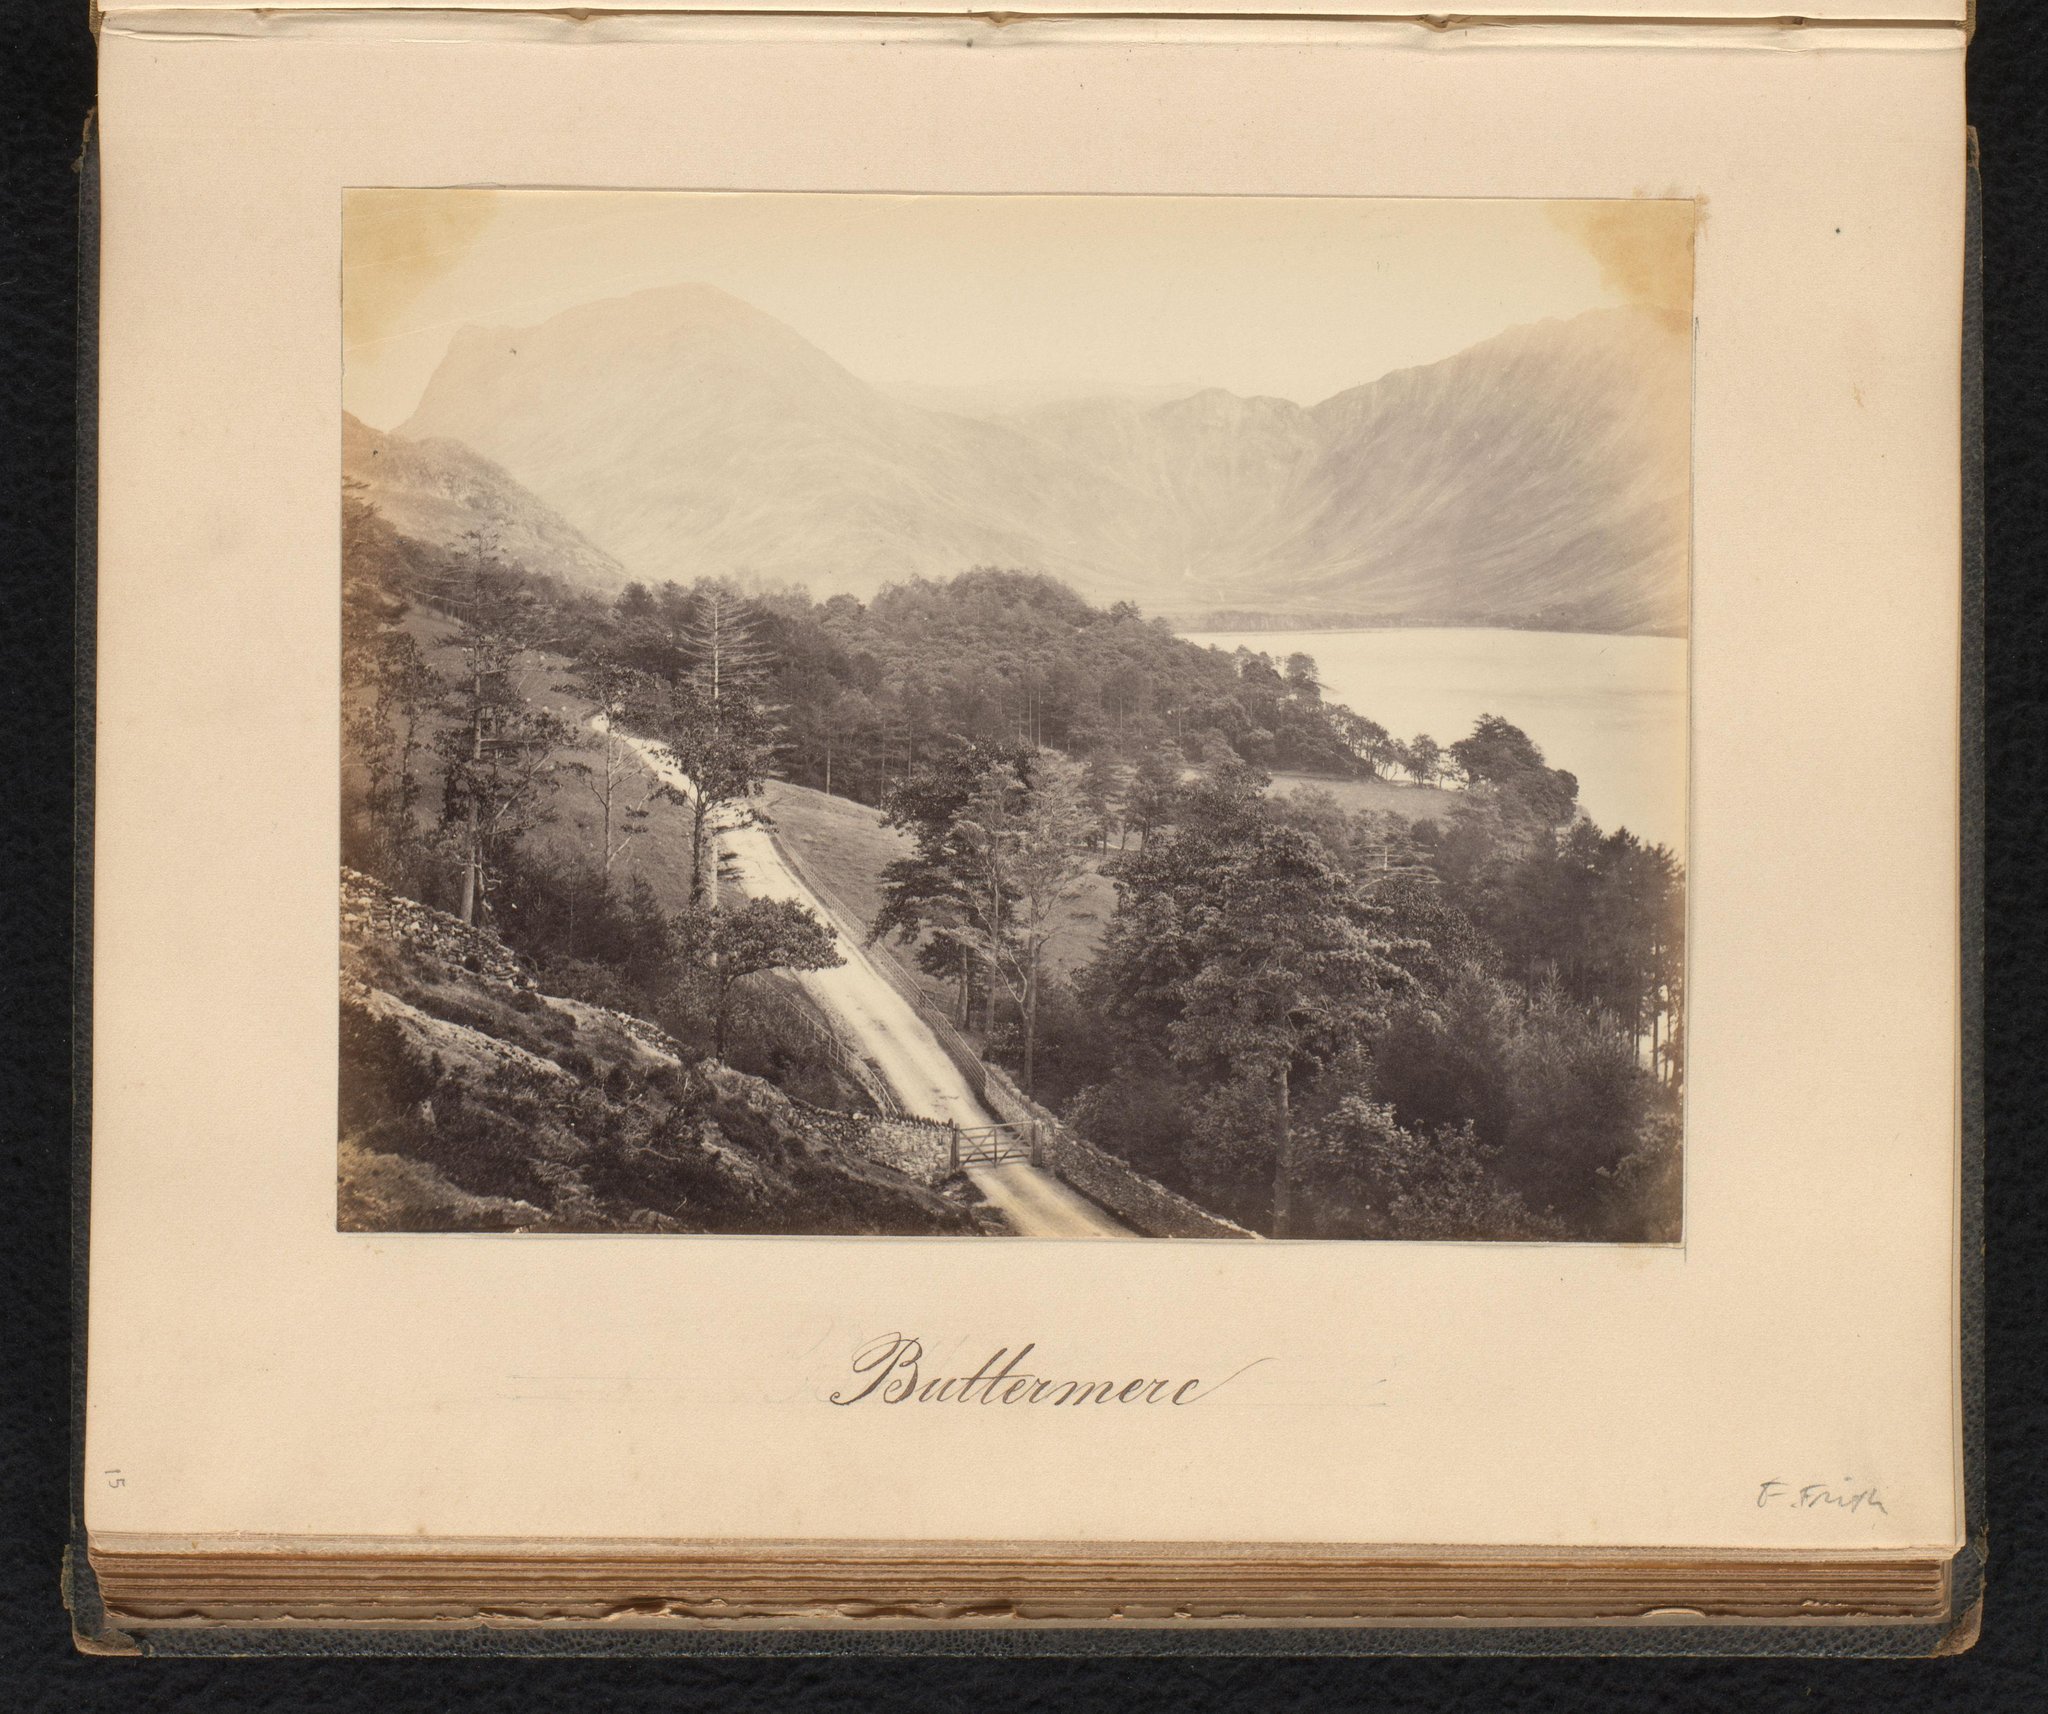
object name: photograph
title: Gezicht op Buttermere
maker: francis frith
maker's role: publisher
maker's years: 1822-1898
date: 1860-1870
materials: paper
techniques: albumen print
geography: buttermere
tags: lake